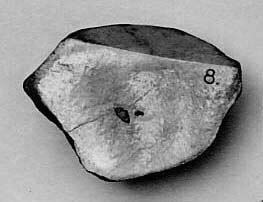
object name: section of a pebble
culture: burmese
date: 1902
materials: jade